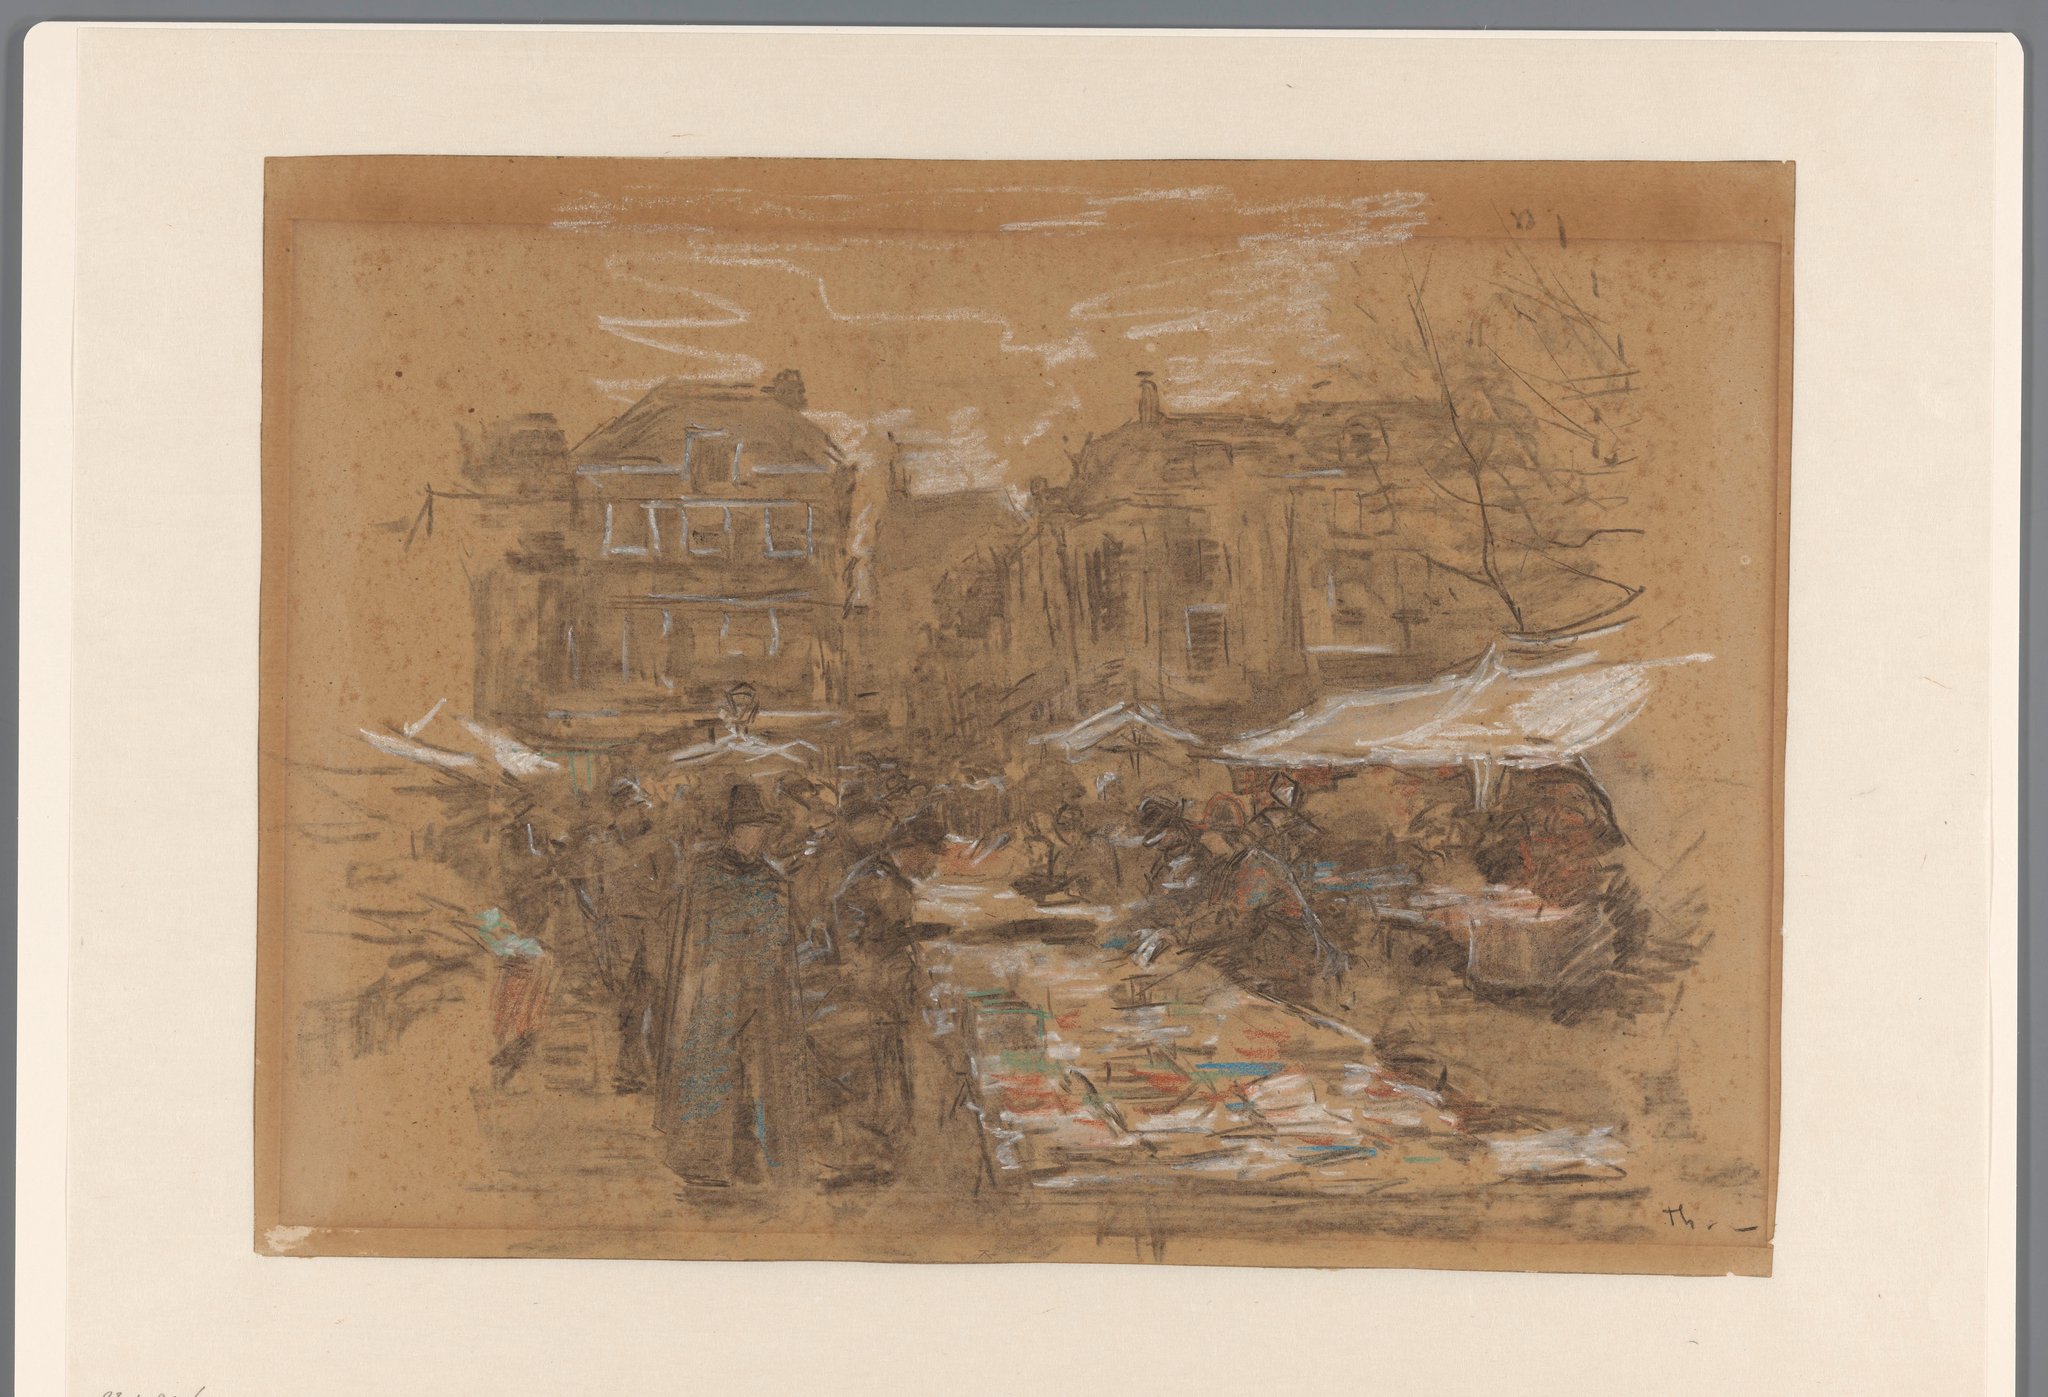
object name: drawing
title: Boekenmarkt in Den Haag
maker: willem bastiaan tholen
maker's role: draughtsman, painter, print maker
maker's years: 1860-1931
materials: chalk, paper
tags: book-stall, kiosk, market, the hague